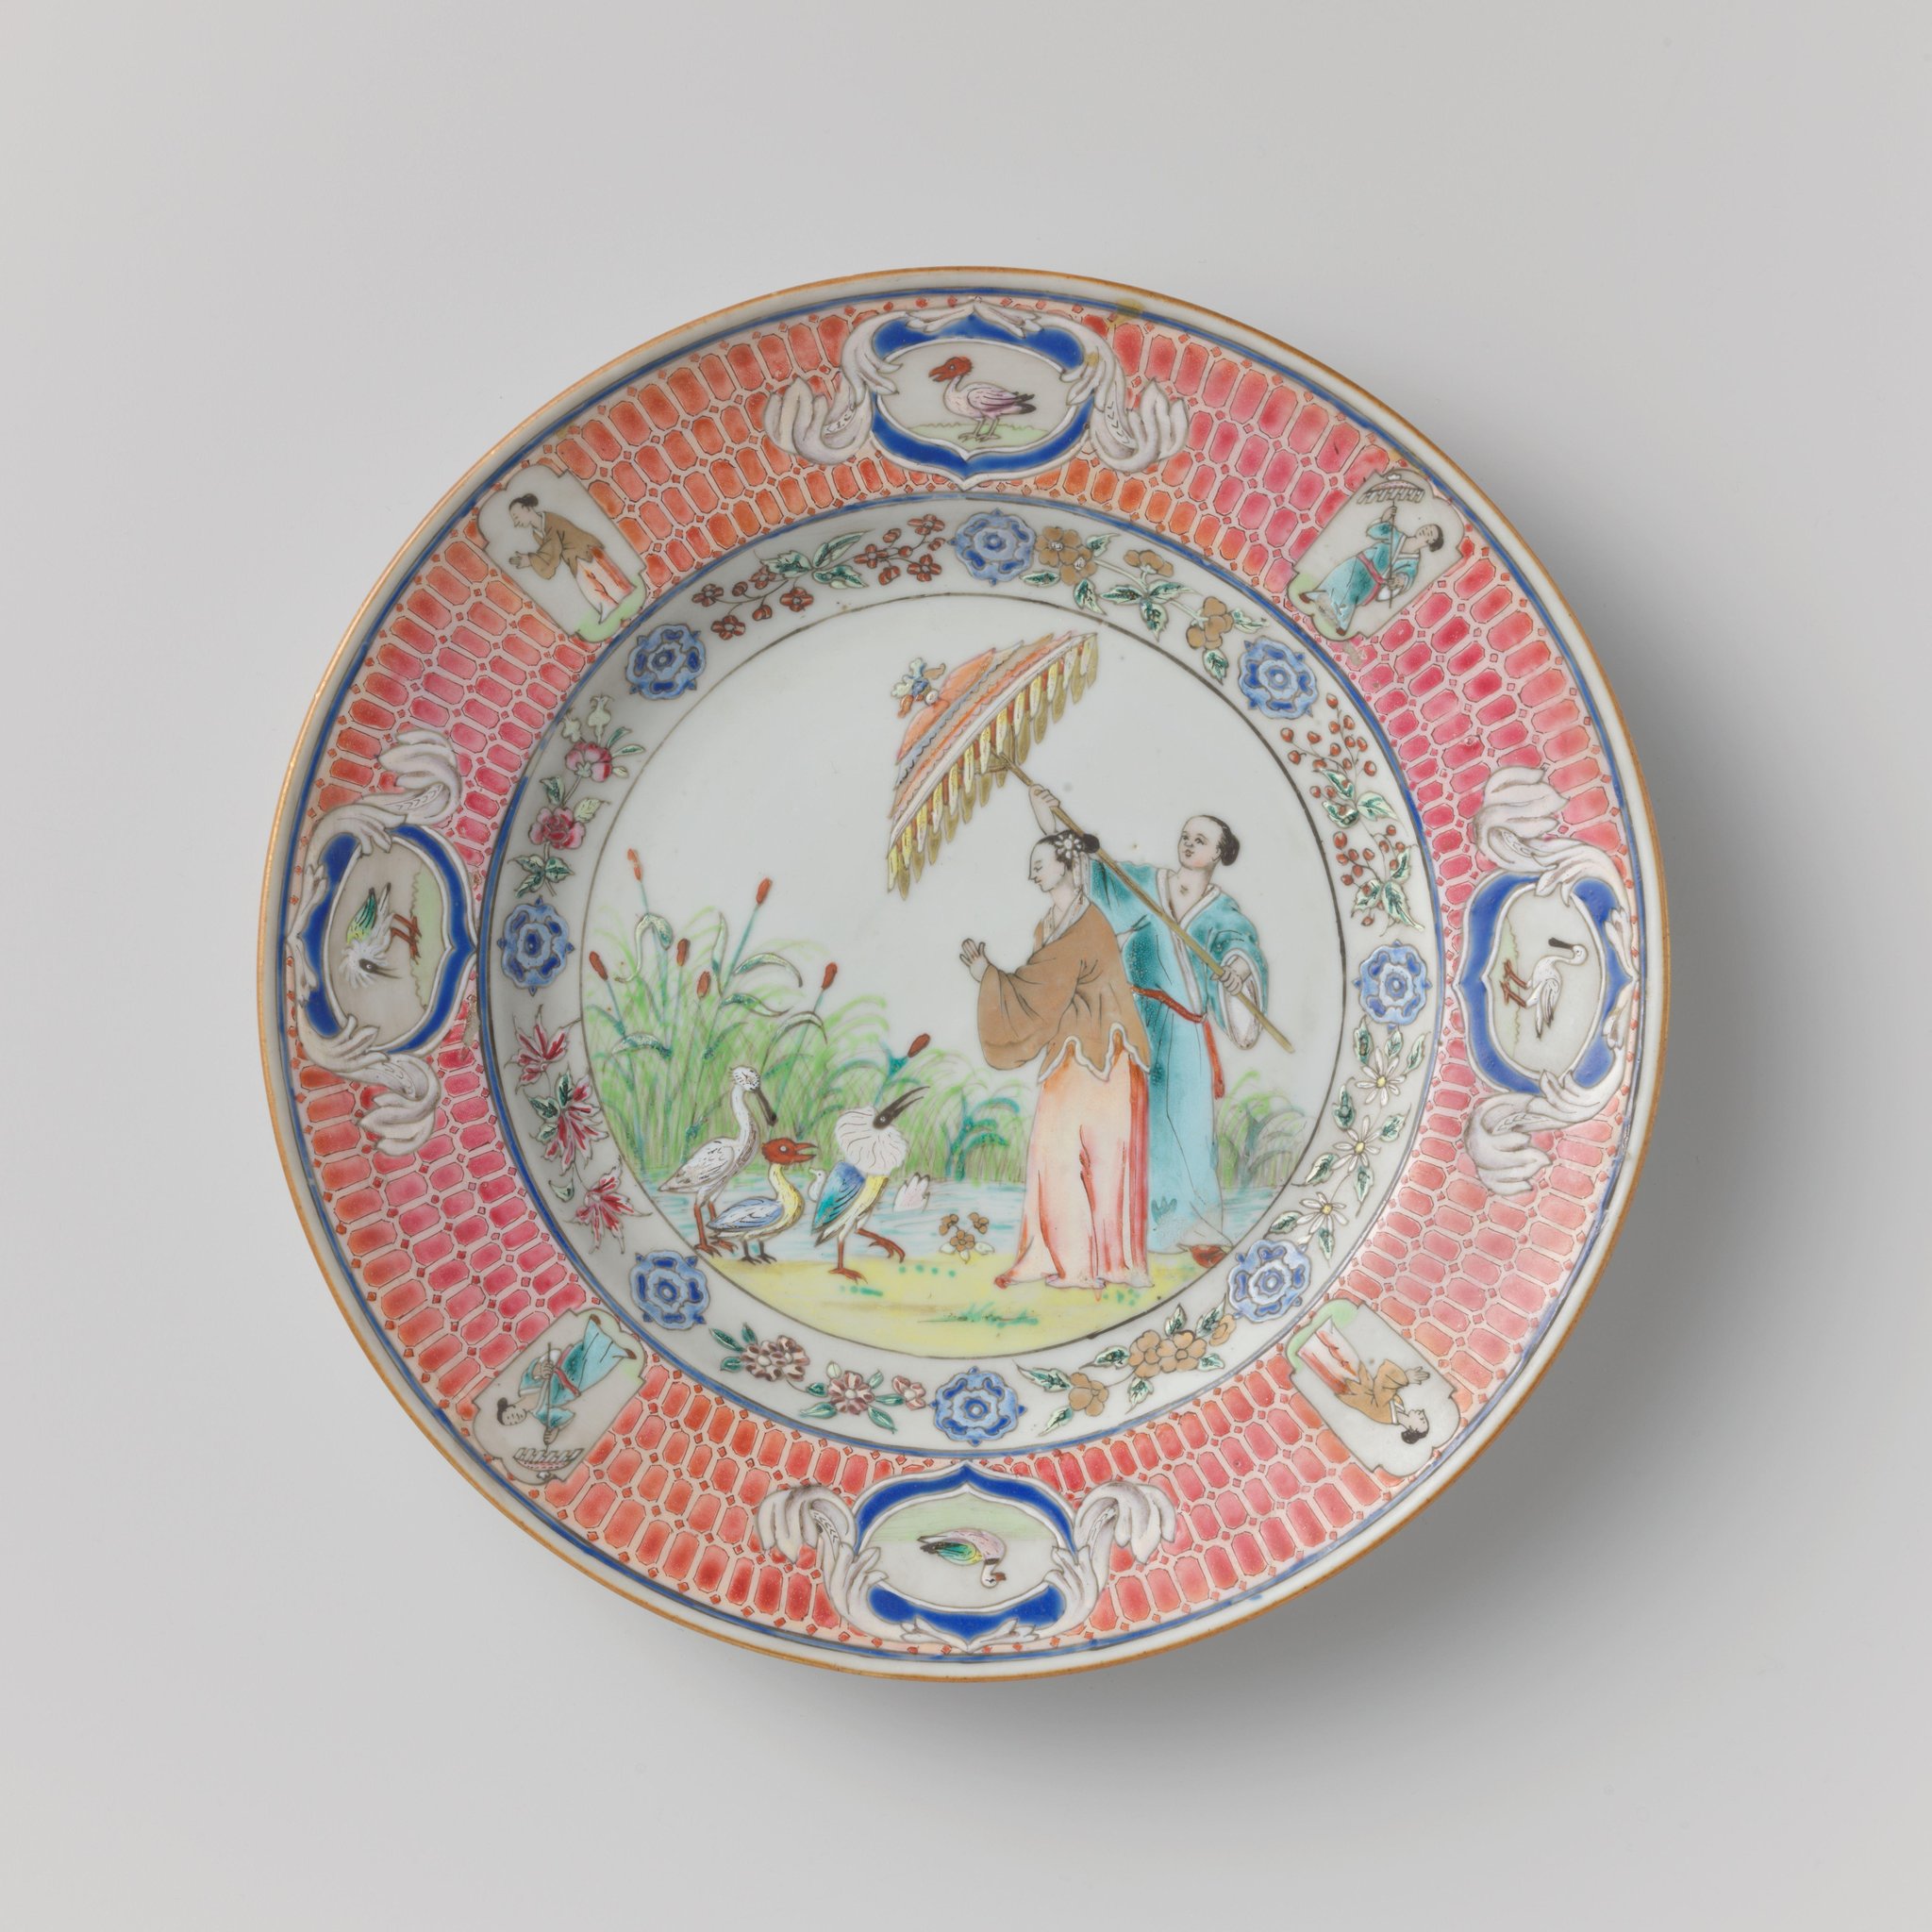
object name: plate dish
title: Plate with an image of The Parasol Lady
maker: Anonymous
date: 1736-1738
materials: glaze, gold, paint, porcelain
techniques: firing, gilding, turning, vitrification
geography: netherlands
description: Besides pagodas and sages, women were a standard feature of the ‘Asian’ imagery of European designers. In 1734, the Dutch draughtsman and designer Cornelis Pronk (1691-1759) created four designs for the decoration of Chinese porcelain for the Dutch East India Company. Pronk never visited Asia. He based his designs on Chinese examples known to him, possibly in the plate on the right, combined with a touch of fantasy.